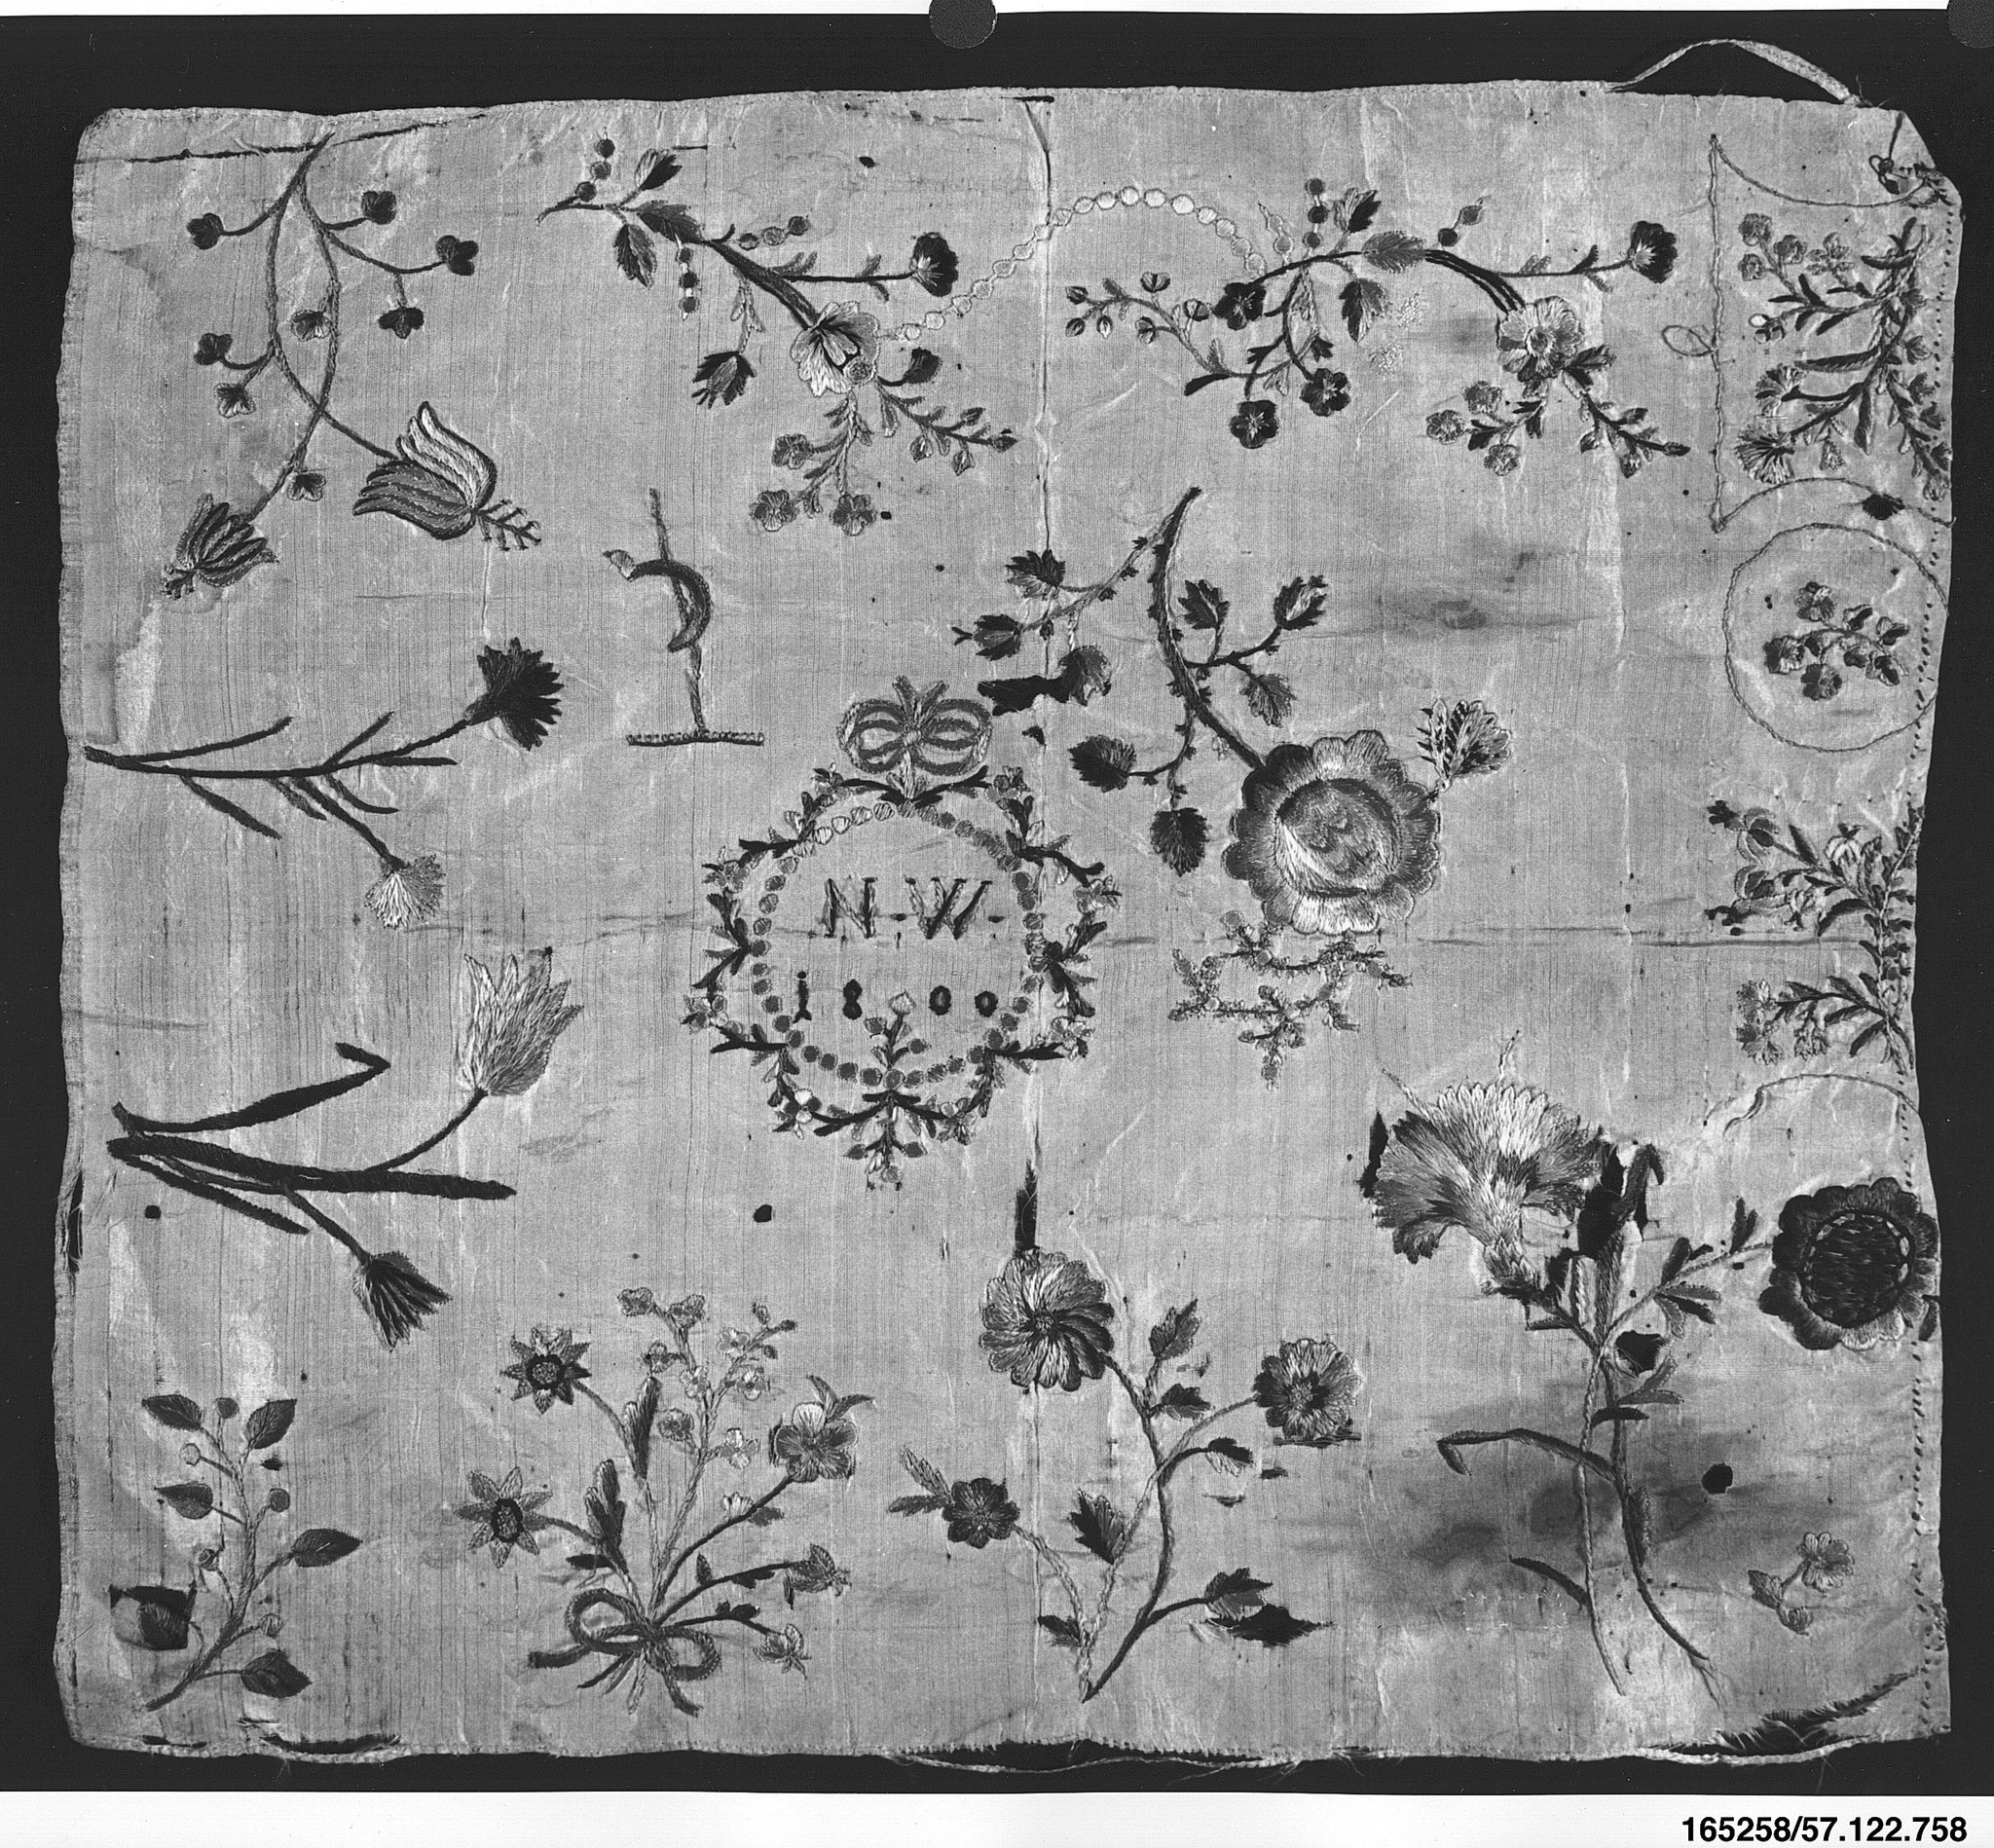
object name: sampler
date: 1800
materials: silk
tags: flowers,leaves,insignia